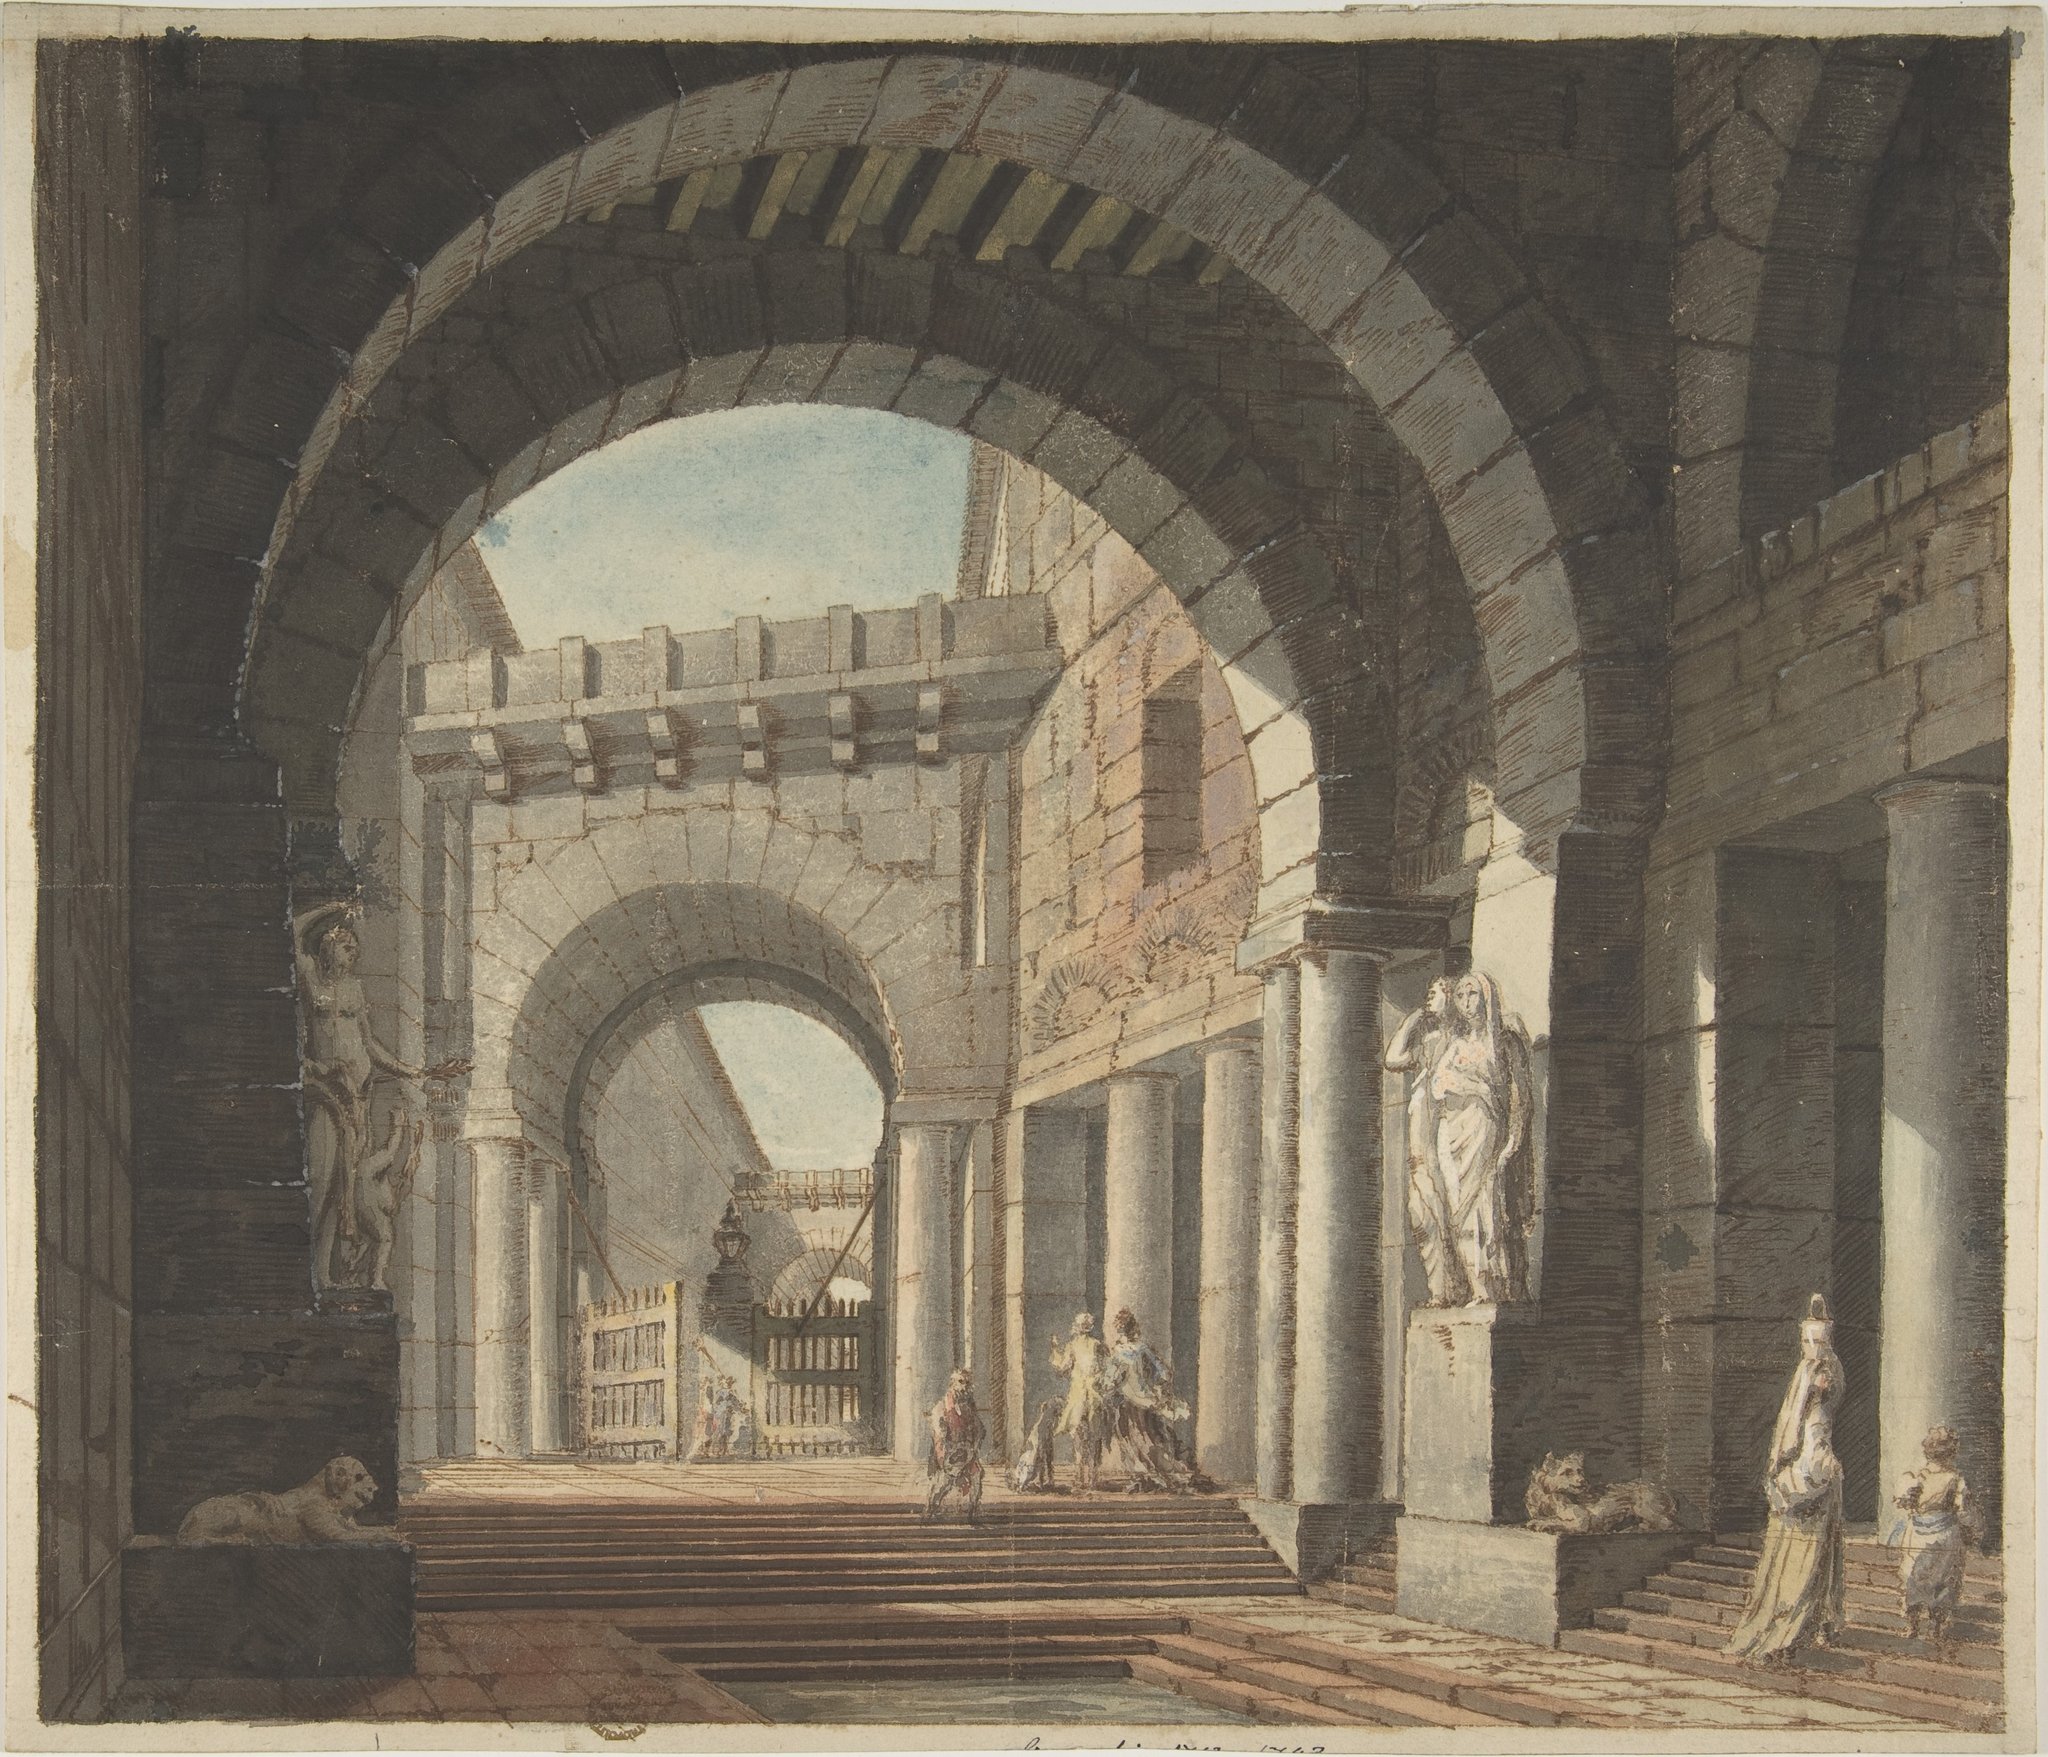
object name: drawing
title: Courtyard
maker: anonymous, italian, 18th century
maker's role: artist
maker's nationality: italian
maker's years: 1700-1800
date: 1701-1800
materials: watercolor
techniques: pen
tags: human figures,arches,courtyards,dogs